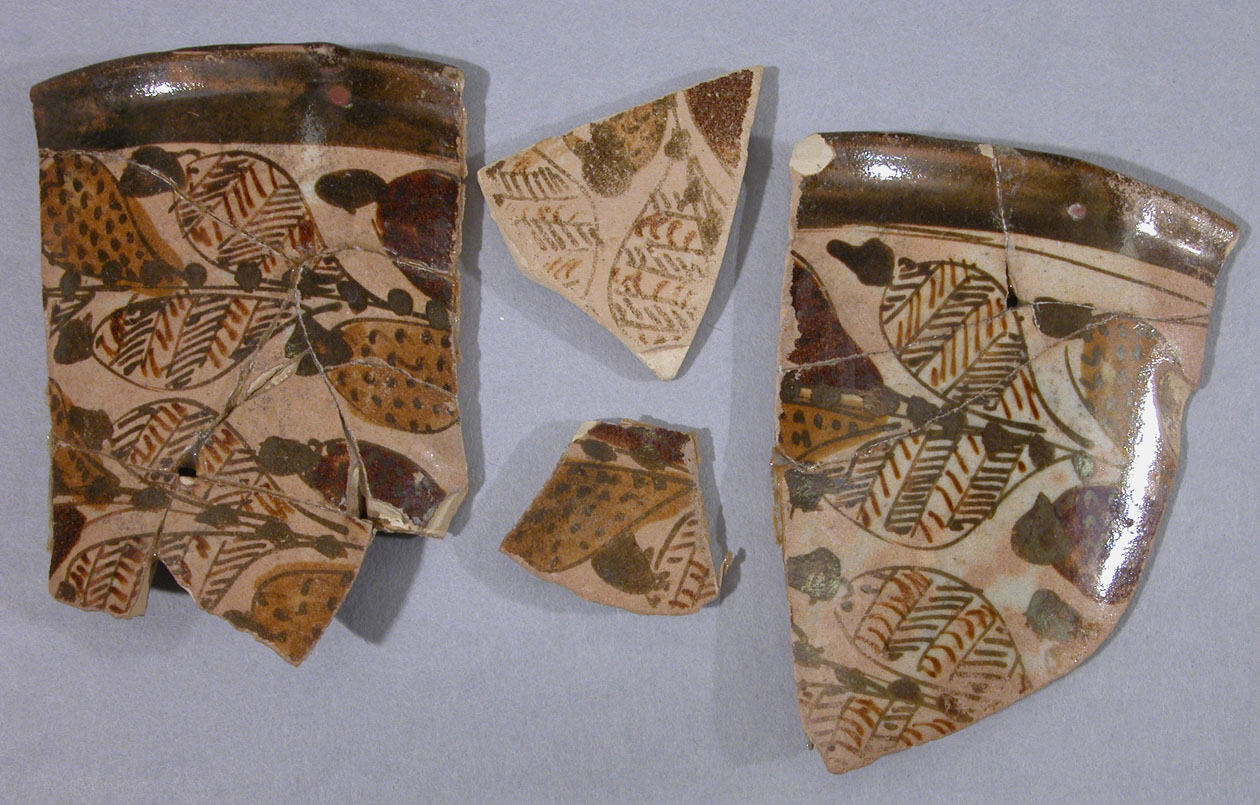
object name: fragment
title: Fragments of Polychrome Luster Vessels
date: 801-900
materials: earthenware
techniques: luster painting, polychrome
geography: iraq